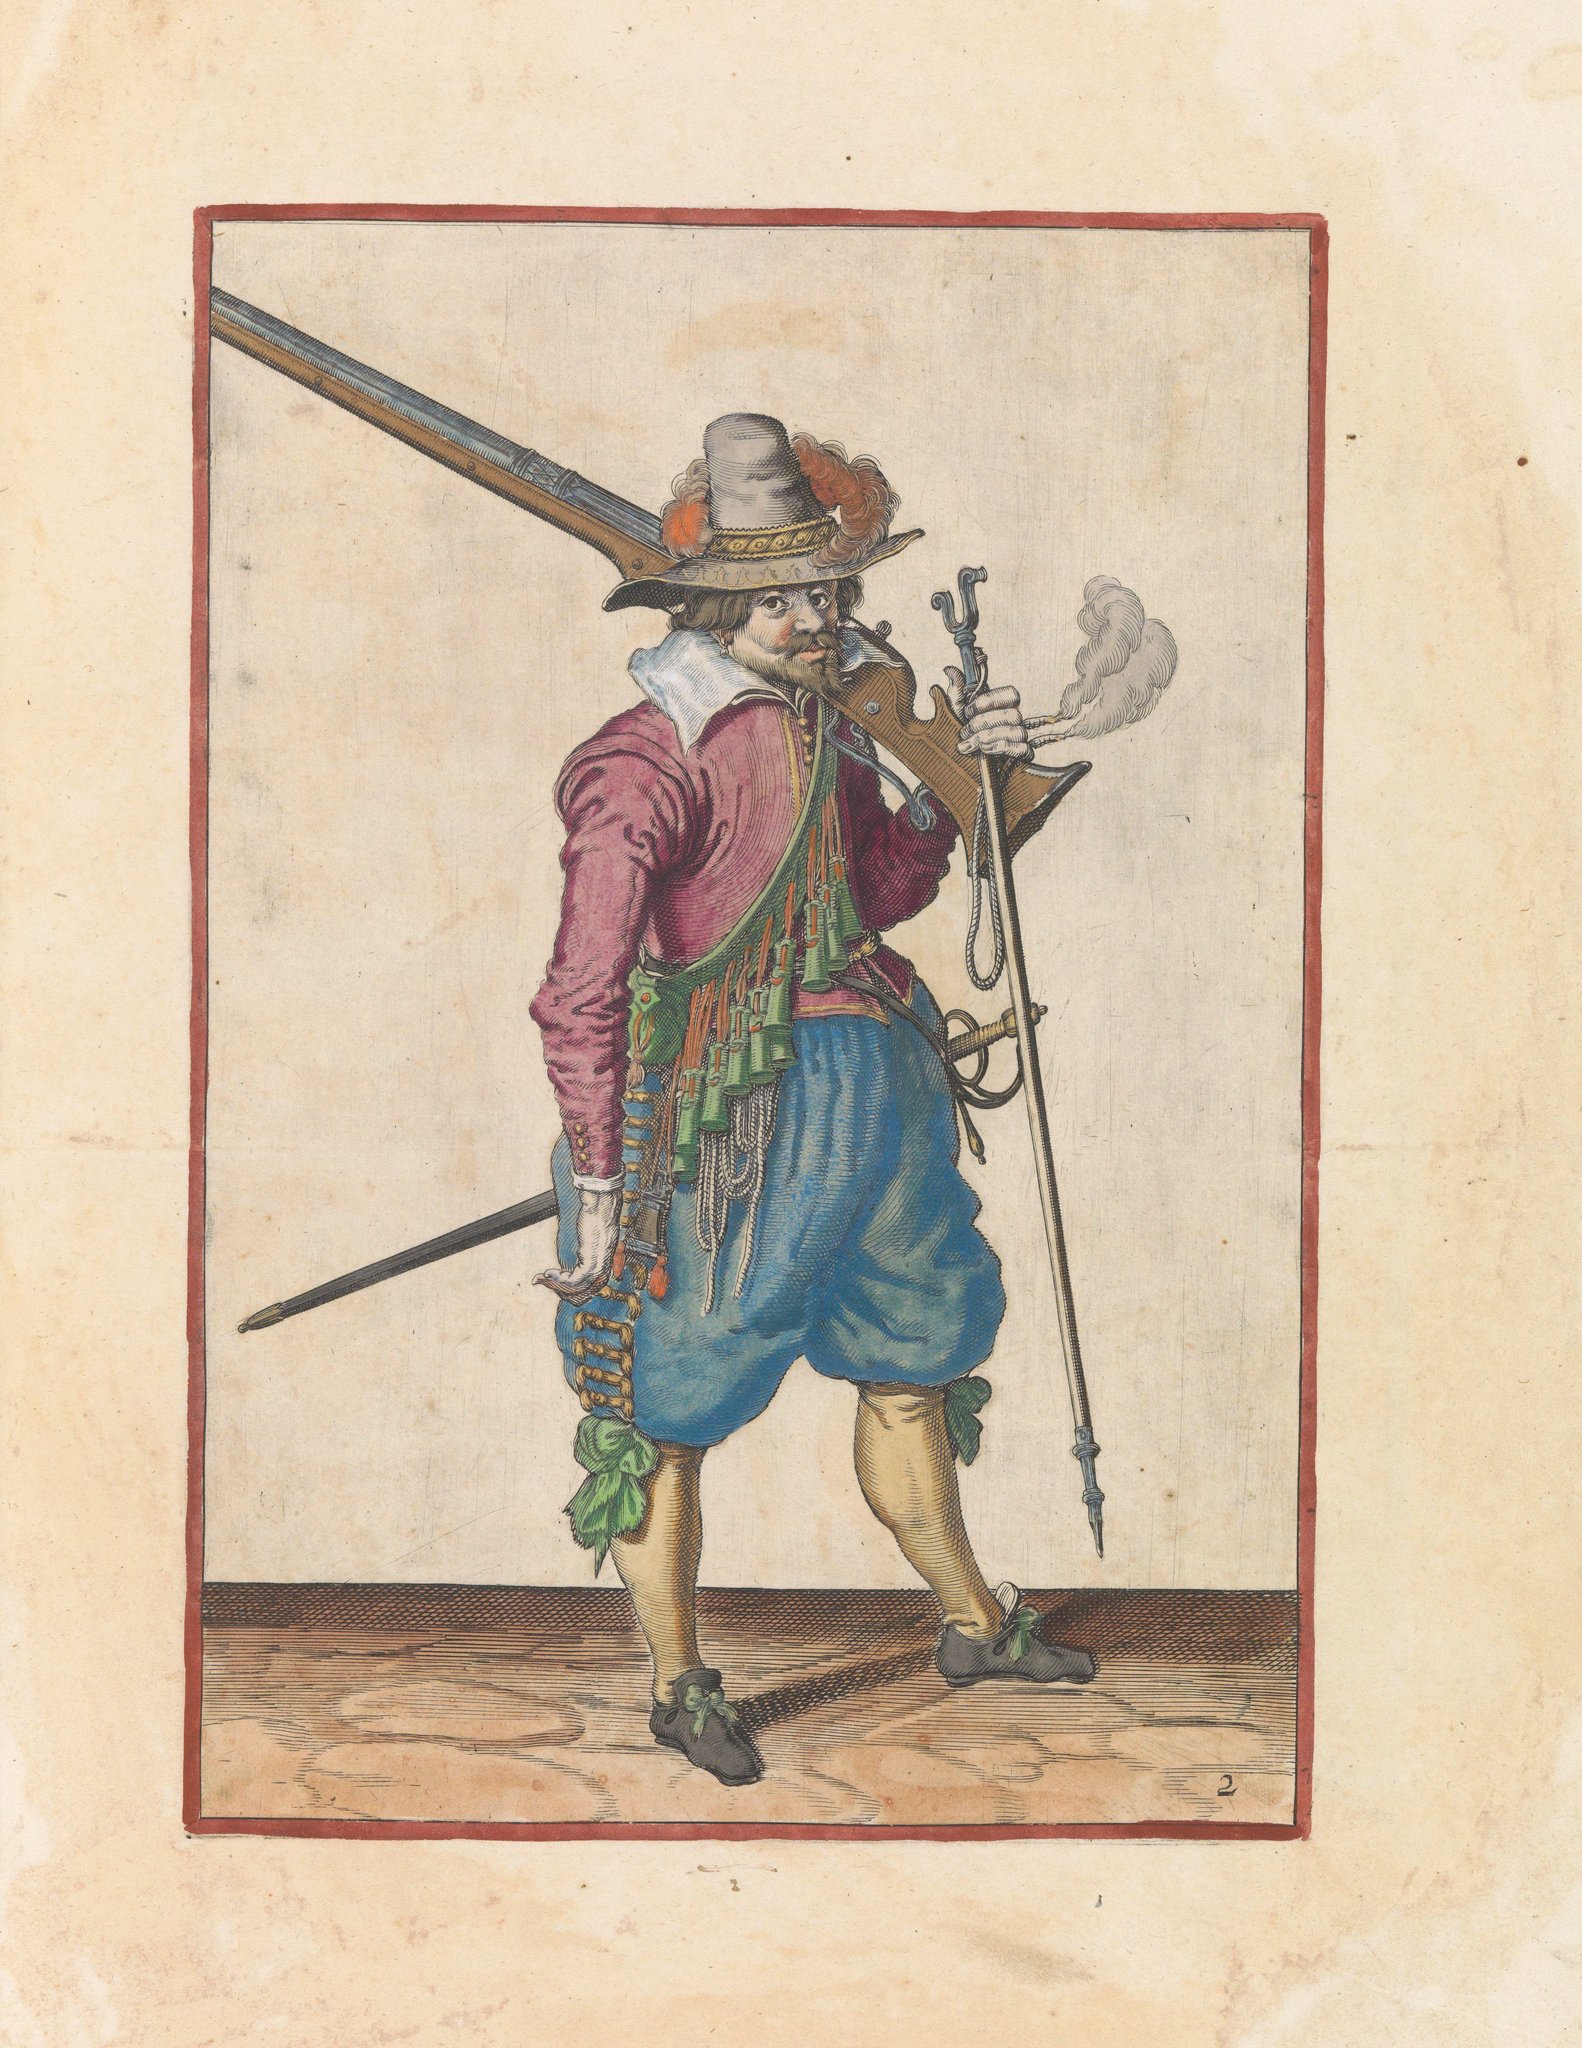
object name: print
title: Soldaat die zijn musket op zijn linkerschouder draagt en zijn furket in zijn linkerhand vasthoudt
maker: jacques de gheyn (ii)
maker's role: painter, print maker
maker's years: 1565-1629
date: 1597-1607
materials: paper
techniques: engraving, hand coloring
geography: the hague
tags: handling of weapons ~ military training, firearms: rifle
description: Een soldaat, ten voeten uit, naar rechts, met een musket (een bepaald type vuurwapen) steunend op zijn linkerschouder. In zijn linkerhand behalve de kolf van het musket ook een furket (musketvork) en een brandende lont. Deze prent is onderdeel van de reeks van 43 met de hand genummerde prenten van musketiers in de Wapenhandelinghe. Op dit is exemplaar het nummer gedrukt.